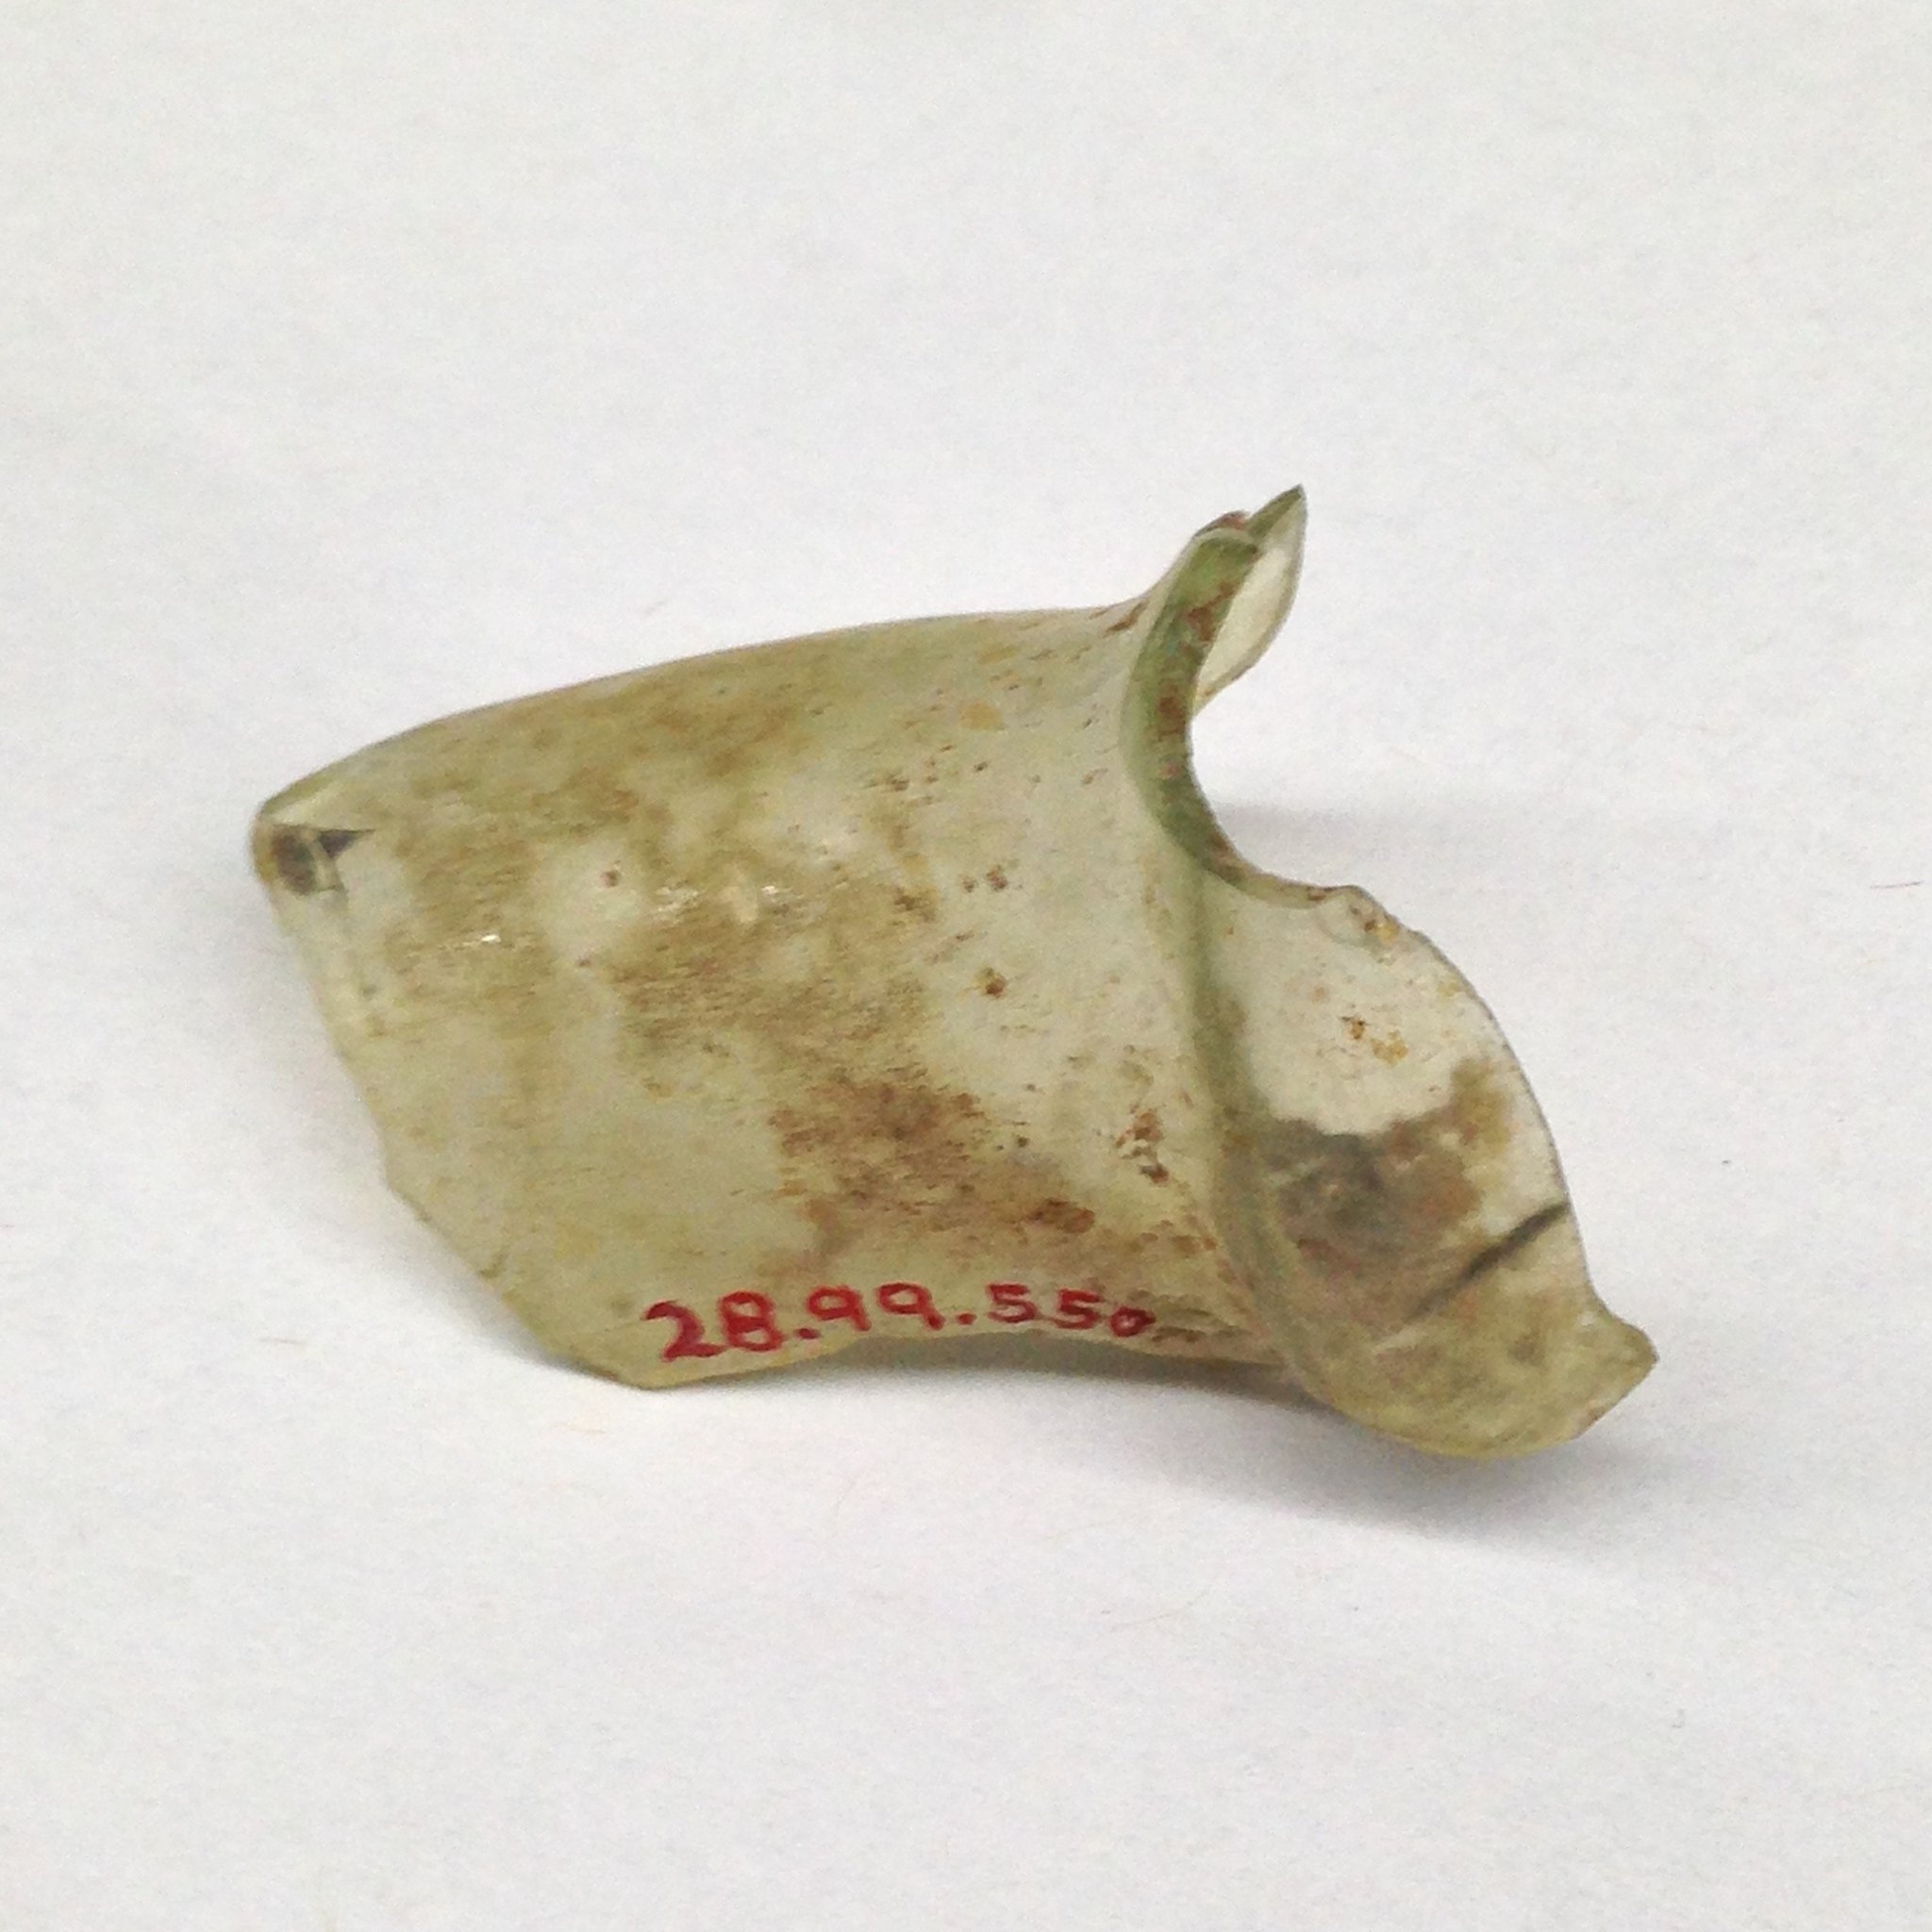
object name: fragment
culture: european or middle eastern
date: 1150-1250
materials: ceramic, glass